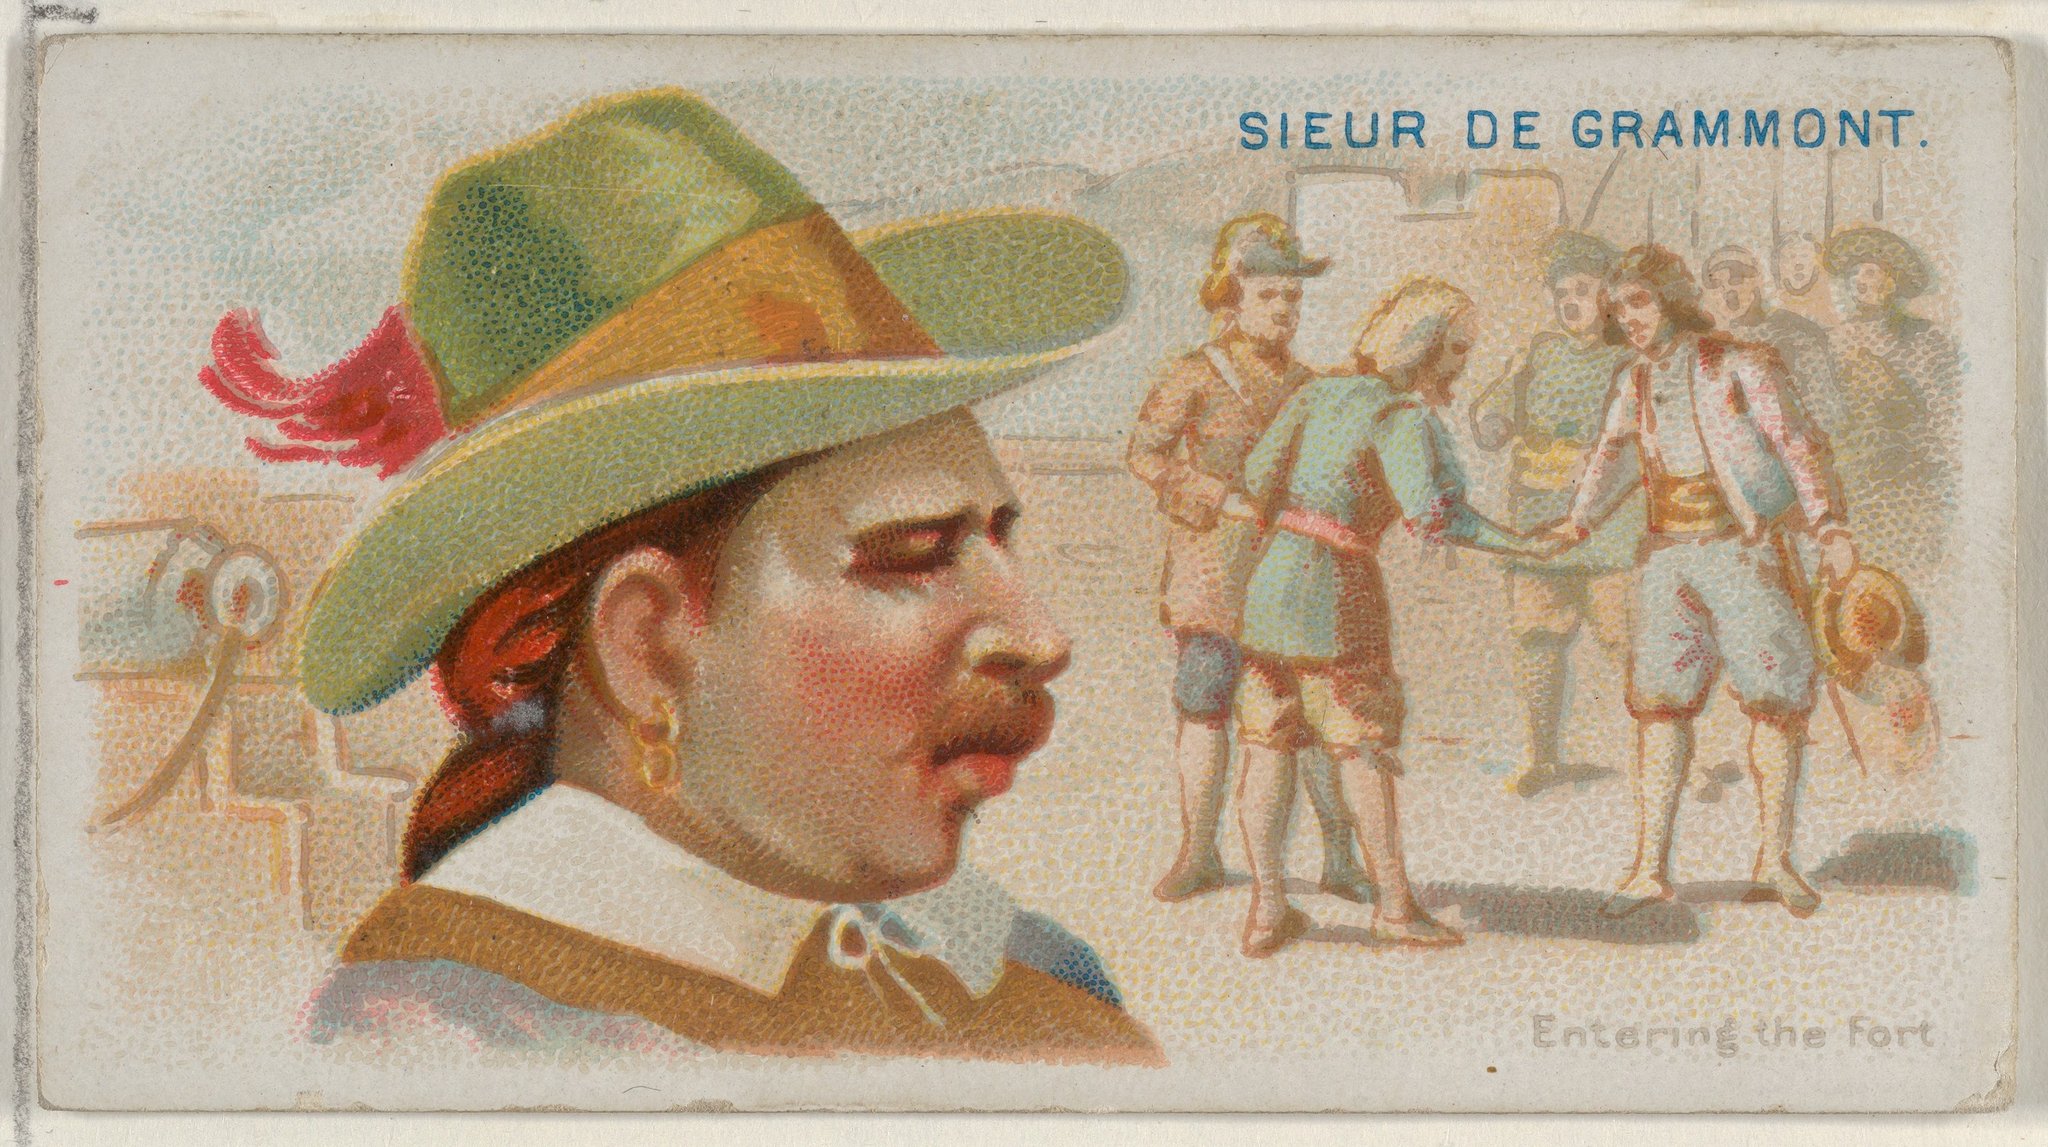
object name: print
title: Sieur de Grammont, Entering the Fort, from the Pirates of the Spanish Main series (N19) for Allen & Ginter Cigarettes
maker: allen & ginter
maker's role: publisher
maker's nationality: american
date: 1888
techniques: color lithograph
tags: men,profiles